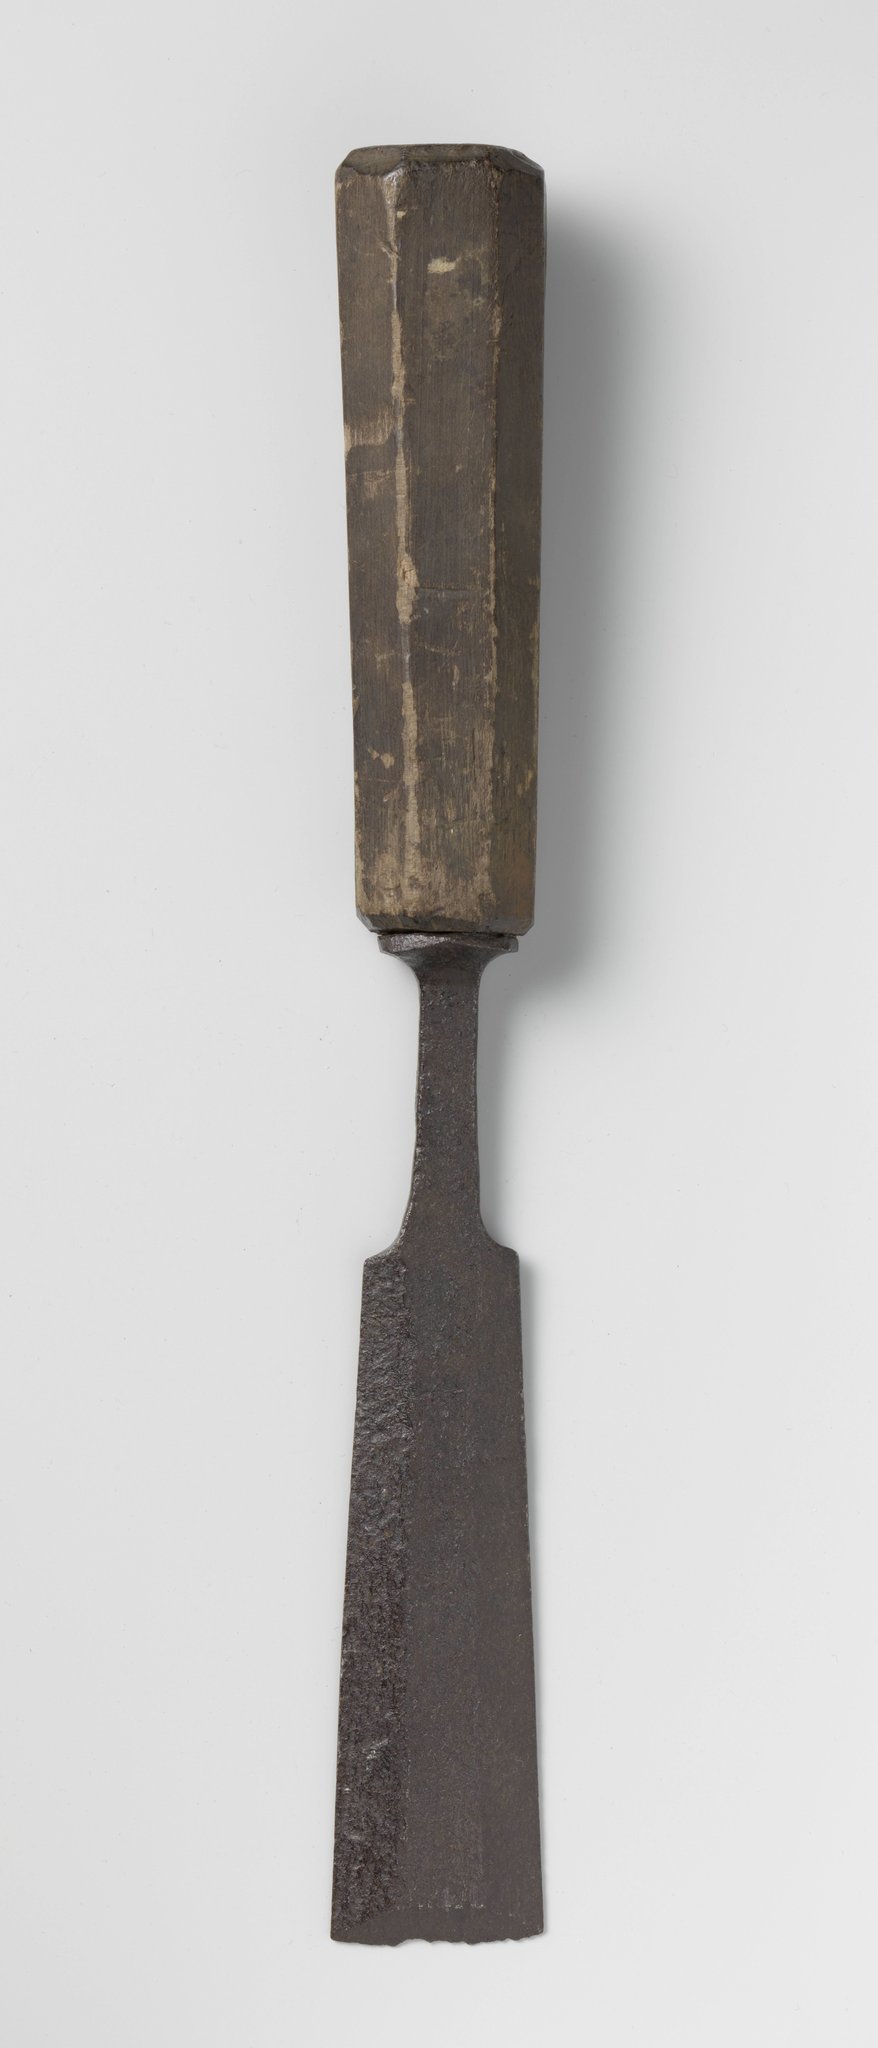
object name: mortise chisel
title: Tools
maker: Anonymous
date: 1590-1596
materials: iron, wood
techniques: cutting, forging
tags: willem barendsz., amsterdam, jacob van heemskerck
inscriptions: mark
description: Each ship was fitted with carpentry tools for making repairs. On Nova Zembla, these tools came in handy for building the ‘Safe House’. It is striking how little the tools have changed over the centuries; many of them can still be found in modern toolboxes.